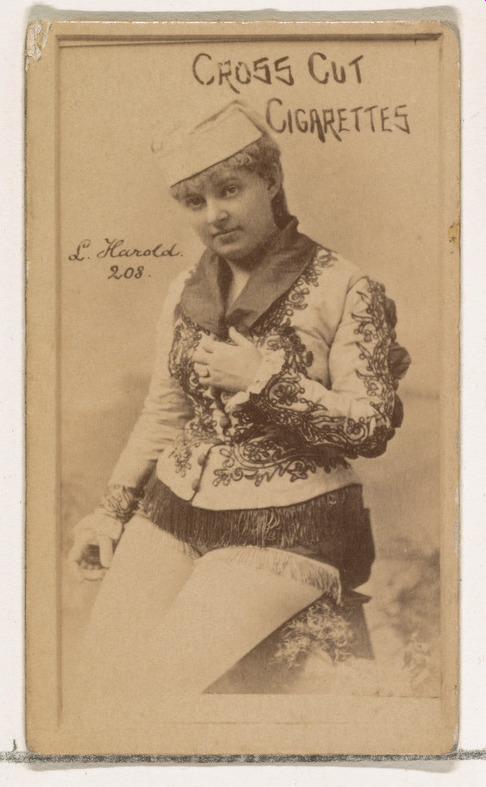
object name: print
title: Card Number 208, L. Harold, from the Actors and Actresses series (N145-1) issued by Duke Sons & Co. to promote Cross Cut Cigarettes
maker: w. duke, sons & co.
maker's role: publisher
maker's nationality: american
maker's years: 1870-1920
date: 1880-1889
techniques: albumen silver print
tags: portraits,women,actresses